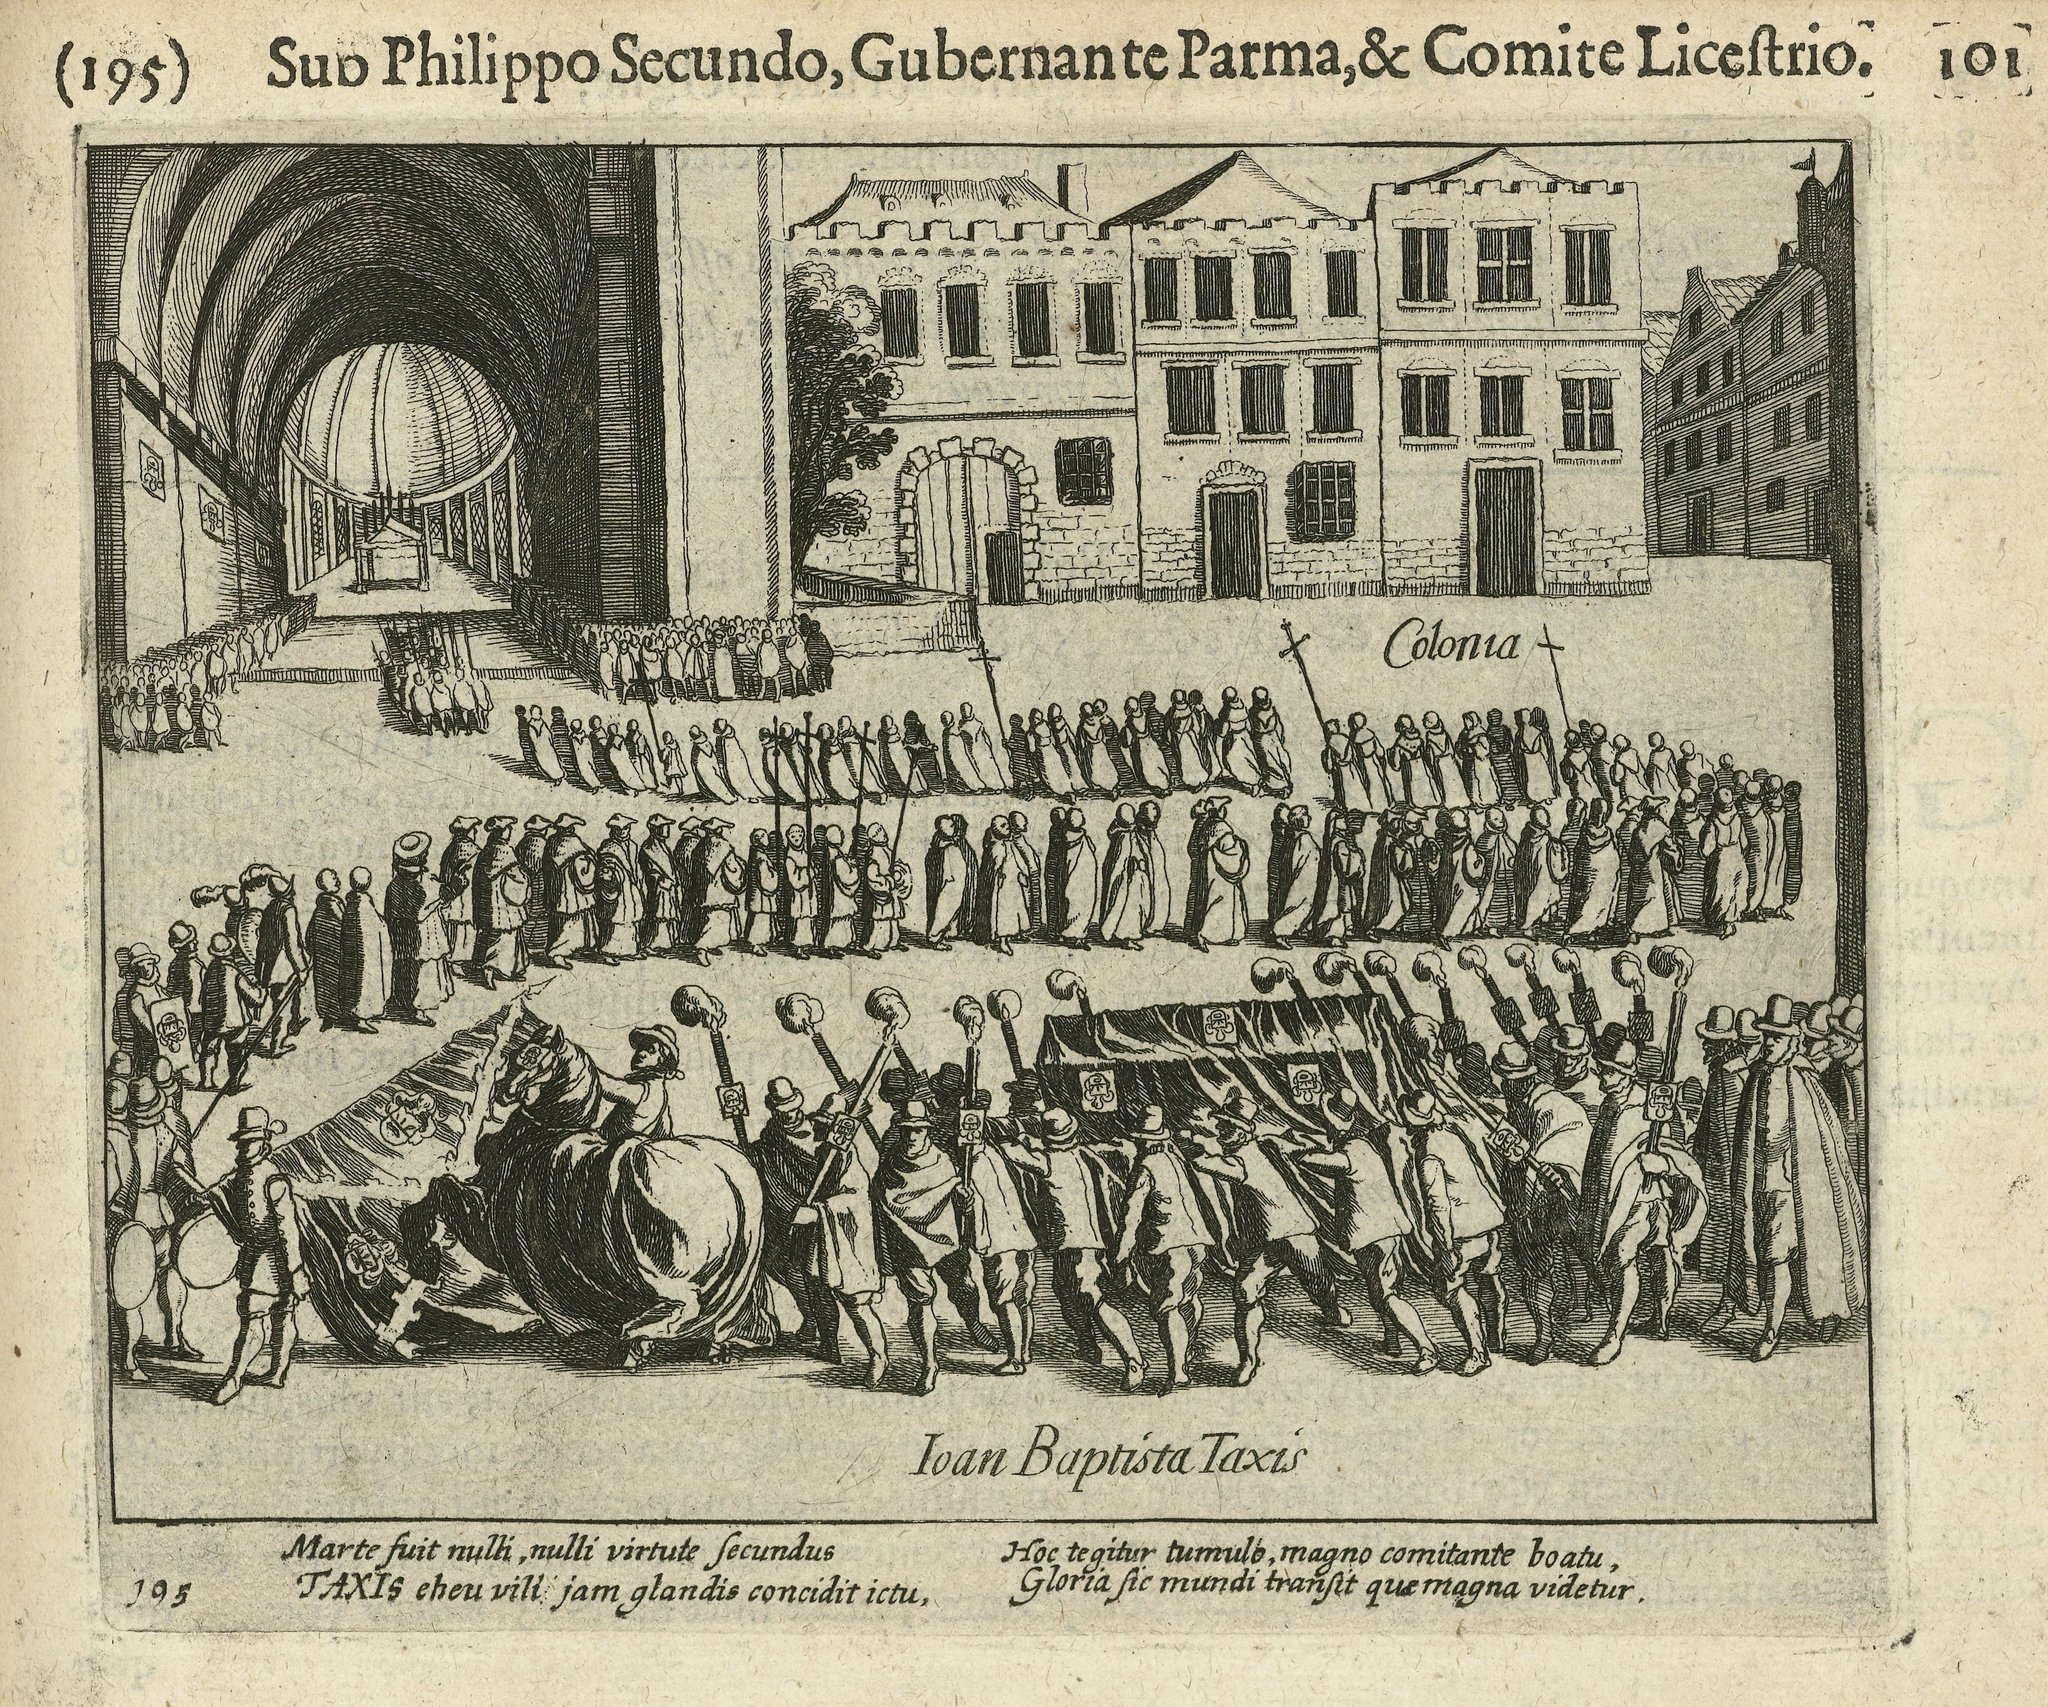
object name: history print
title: Begrafenis van Johann Baptista von Tassis te Keulen, 1588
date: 1613-1615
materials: paper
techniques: etching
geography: northern netherlands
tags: cortege, funeral procession, cologne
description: Begrafenis van Johann Baptista von Tassis, gesneuveld bij het beleg van Bonn, te Keulen, 26 april 1588. Episode uit de Keulse Oorlog. Met onderschrift van 4 regels in het Latijn. Genummerd 195. Bedrukt op achterzijde met tekst in het Latijn.